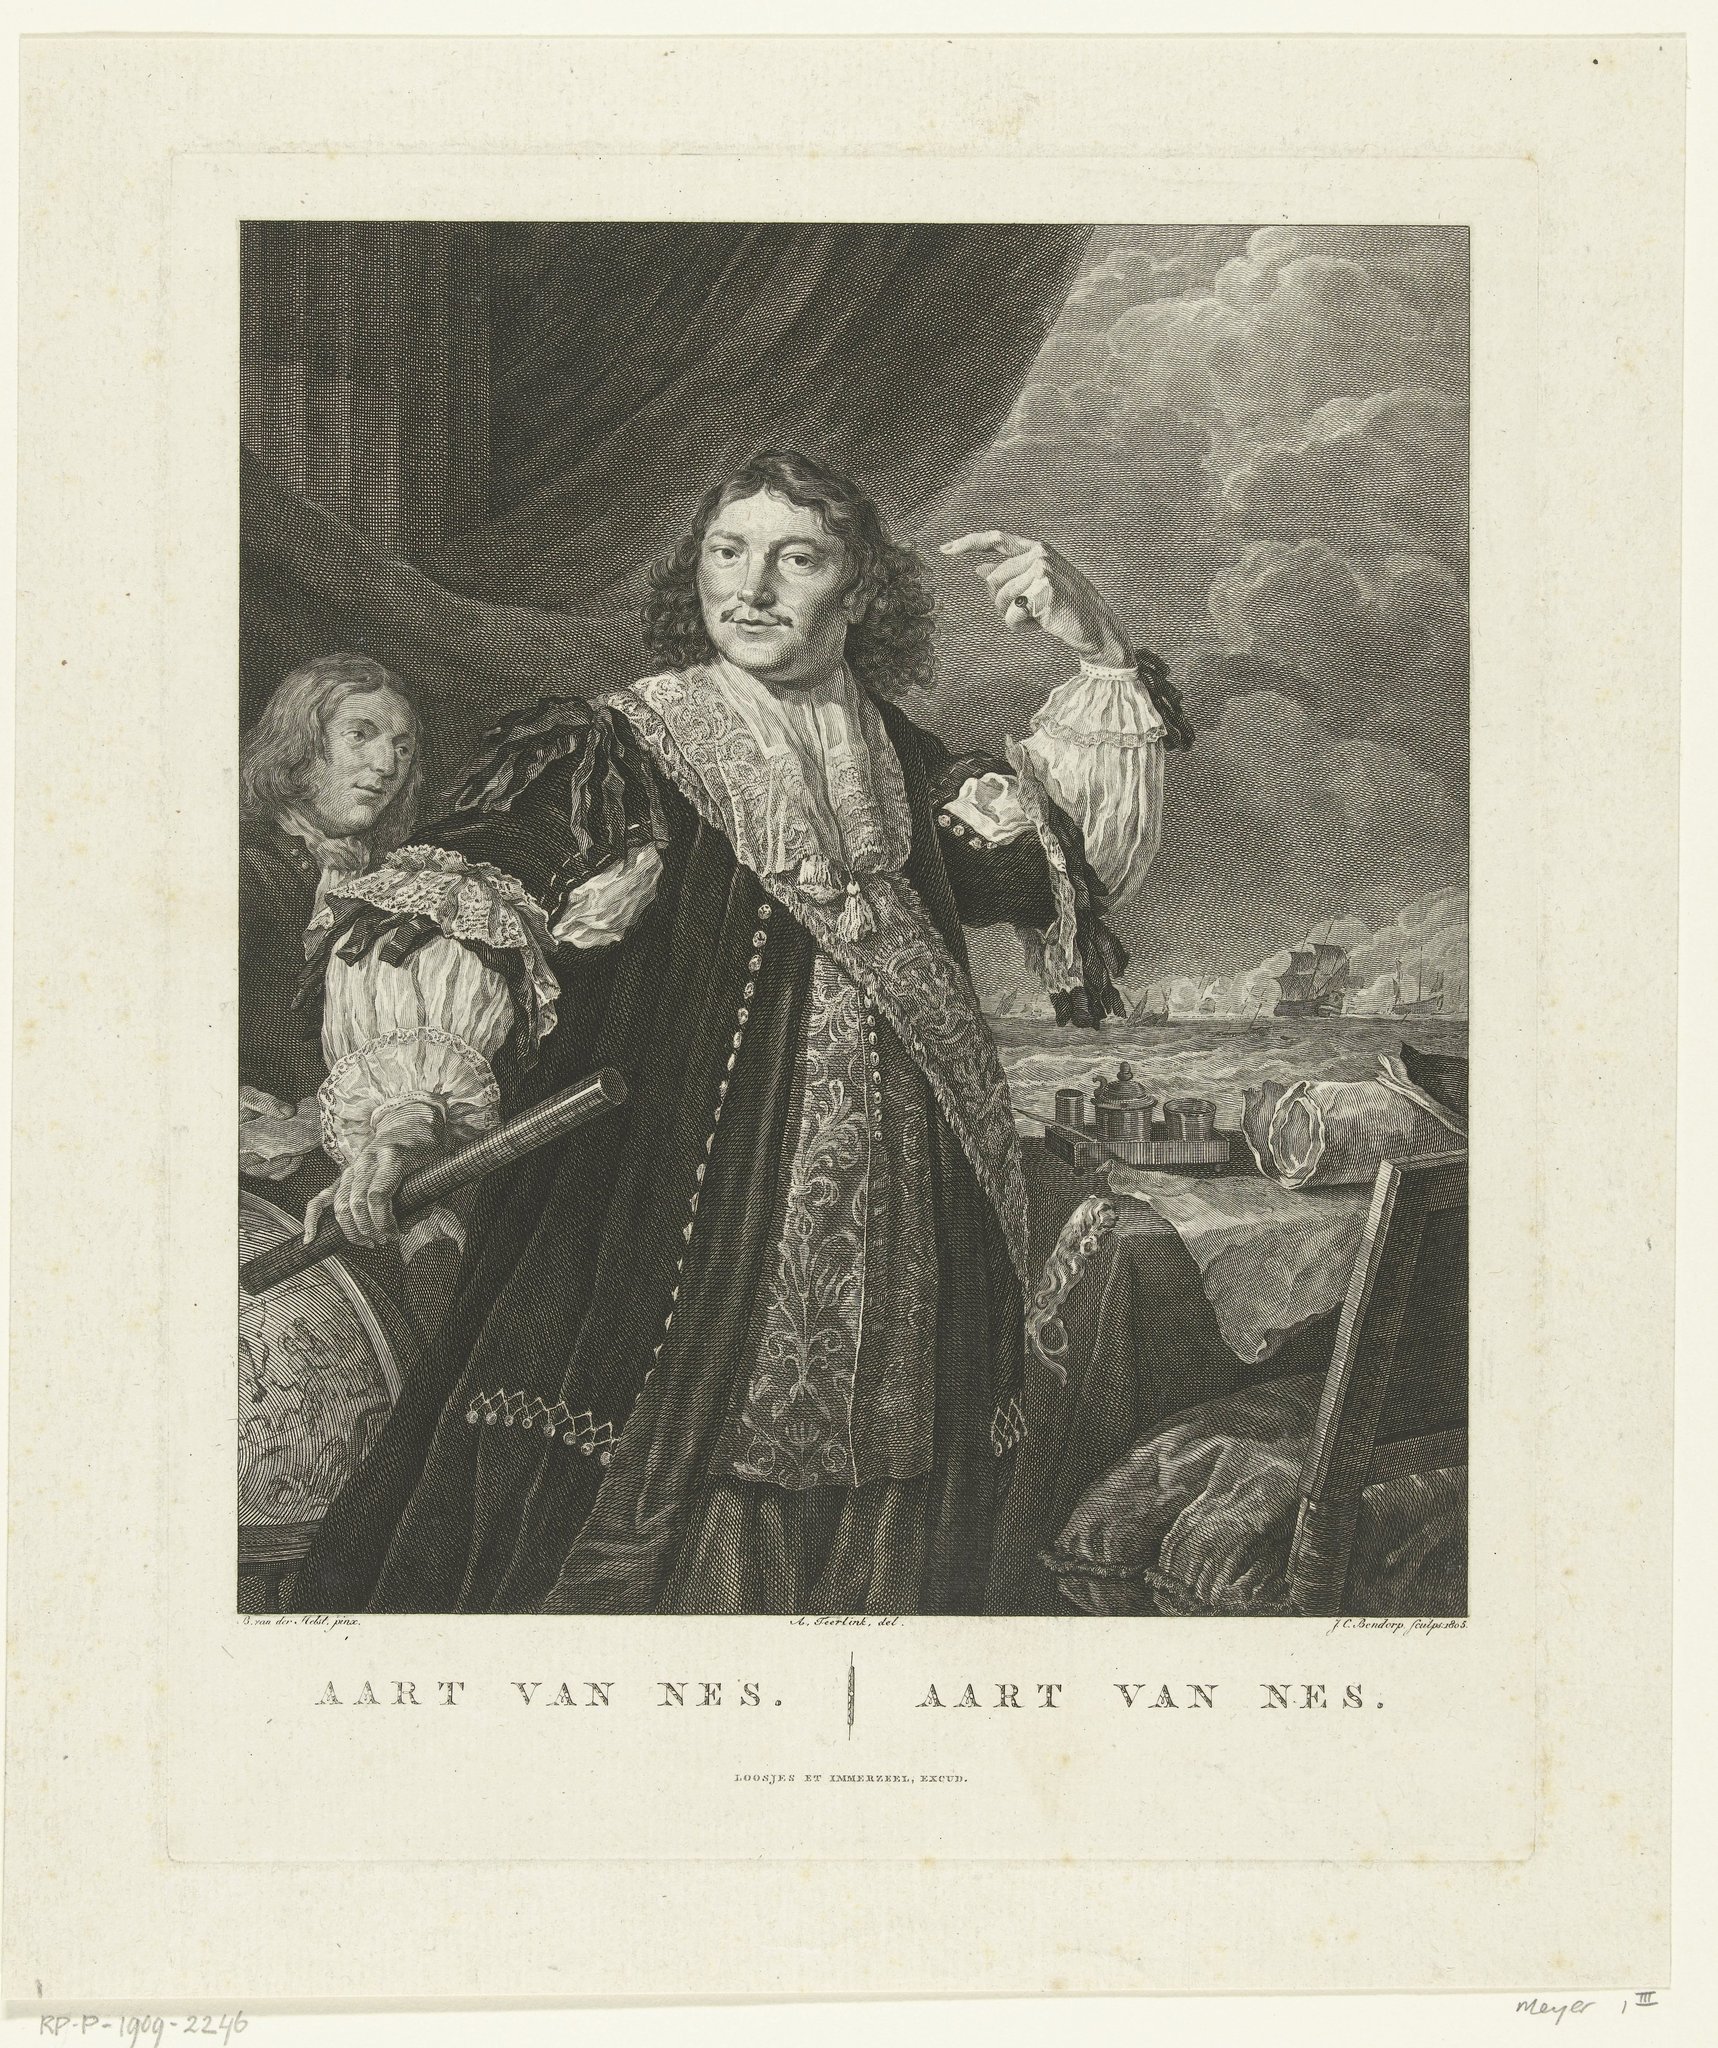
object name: print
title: Portret van marineofficier Aert Jansz. van Nes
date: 1805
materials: paper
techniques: engraving, etching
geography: netherlands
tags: rotterdam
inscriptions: collector's mark: Lugt 2228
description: Prent naar tekening van Abraham Teerlink. Teerlink baseerde zich op een schilderij van Bartholomeus van der Helst.